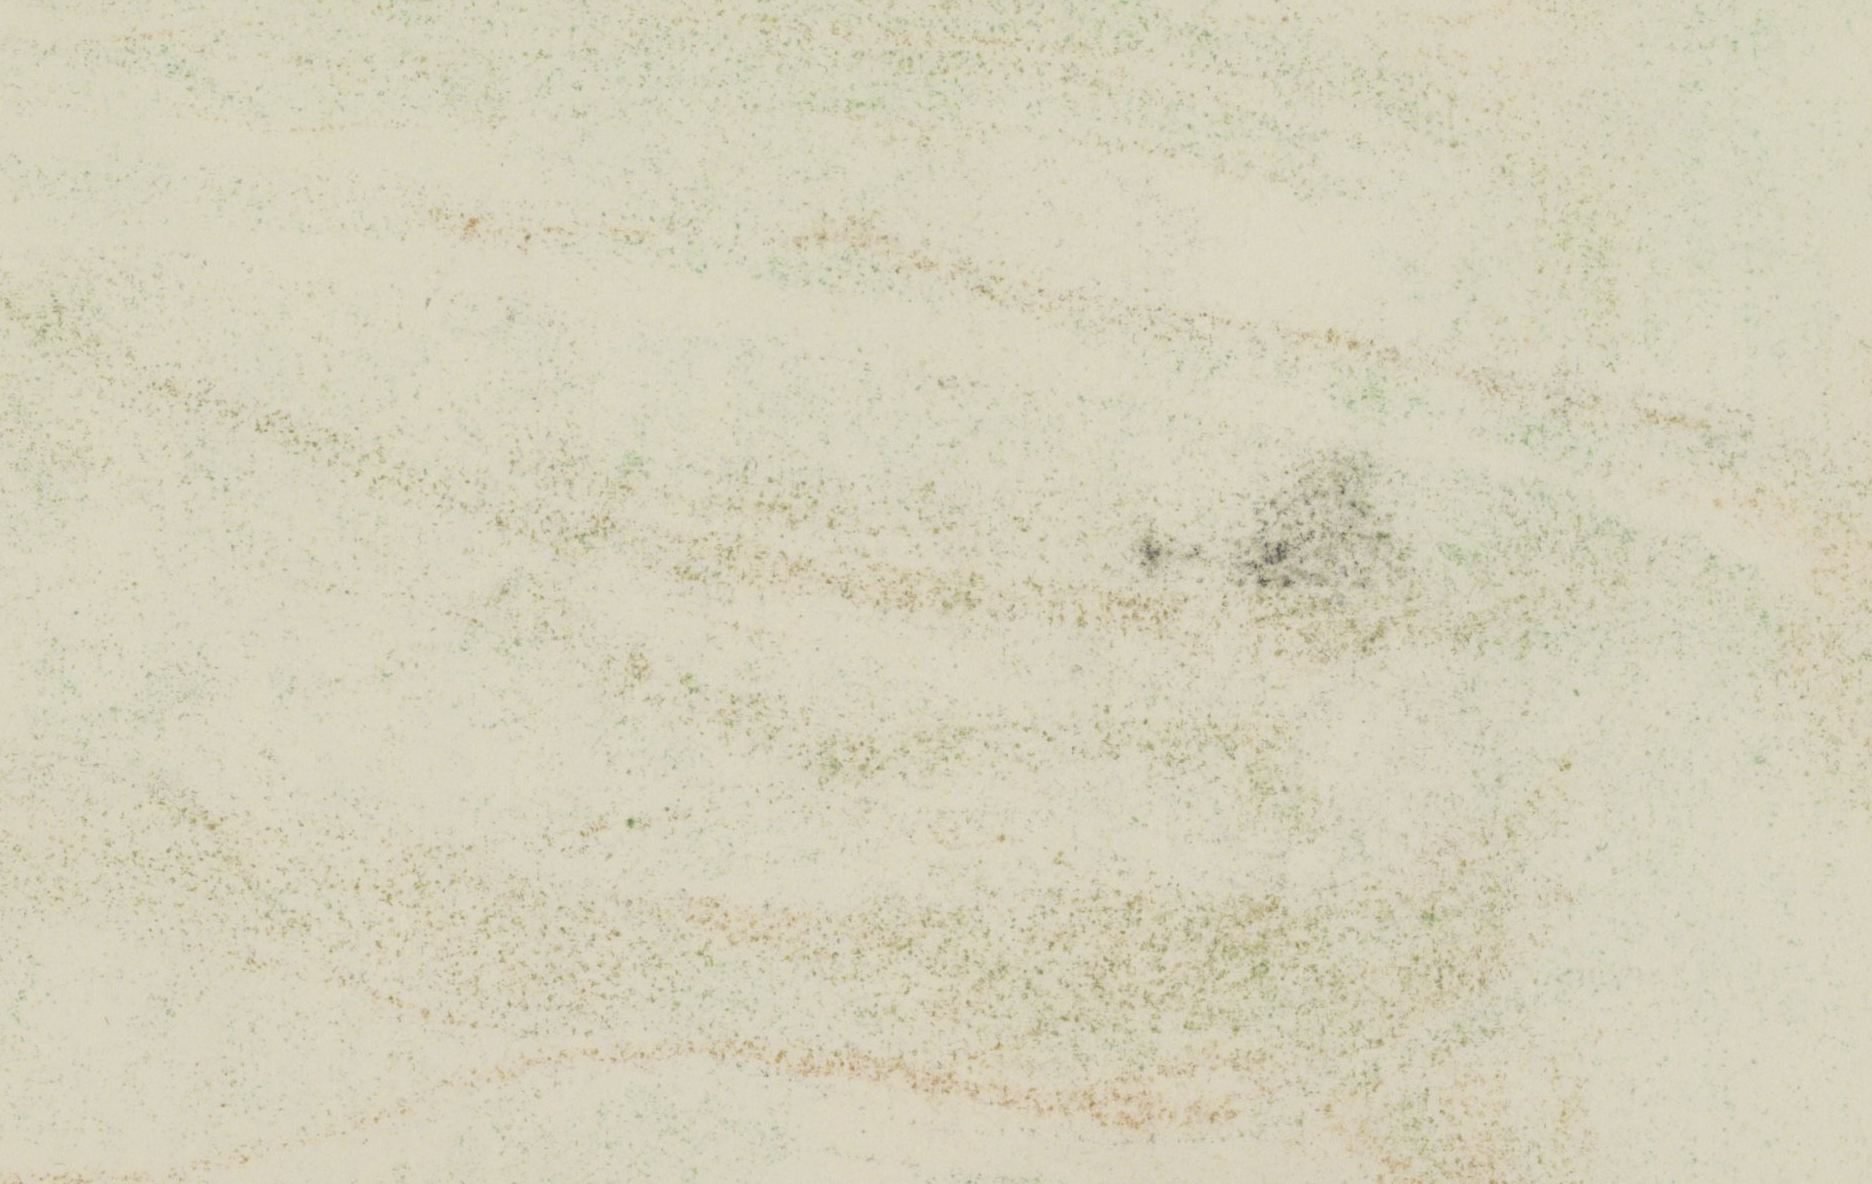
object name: sketchbook leaf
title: Boomstammen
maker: a.a.l. de grammont-hubrecht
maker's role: draughtsman, painter, print maker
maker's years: 1855-1913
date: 1892-1913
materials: chalk, paper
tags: trees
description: Mogelijk een abklatsch van een niet langer in het schetsboek aanwezige tekening of een vervaagde schets. Blad 19 recto uit een schetsboek met 31 bladen.